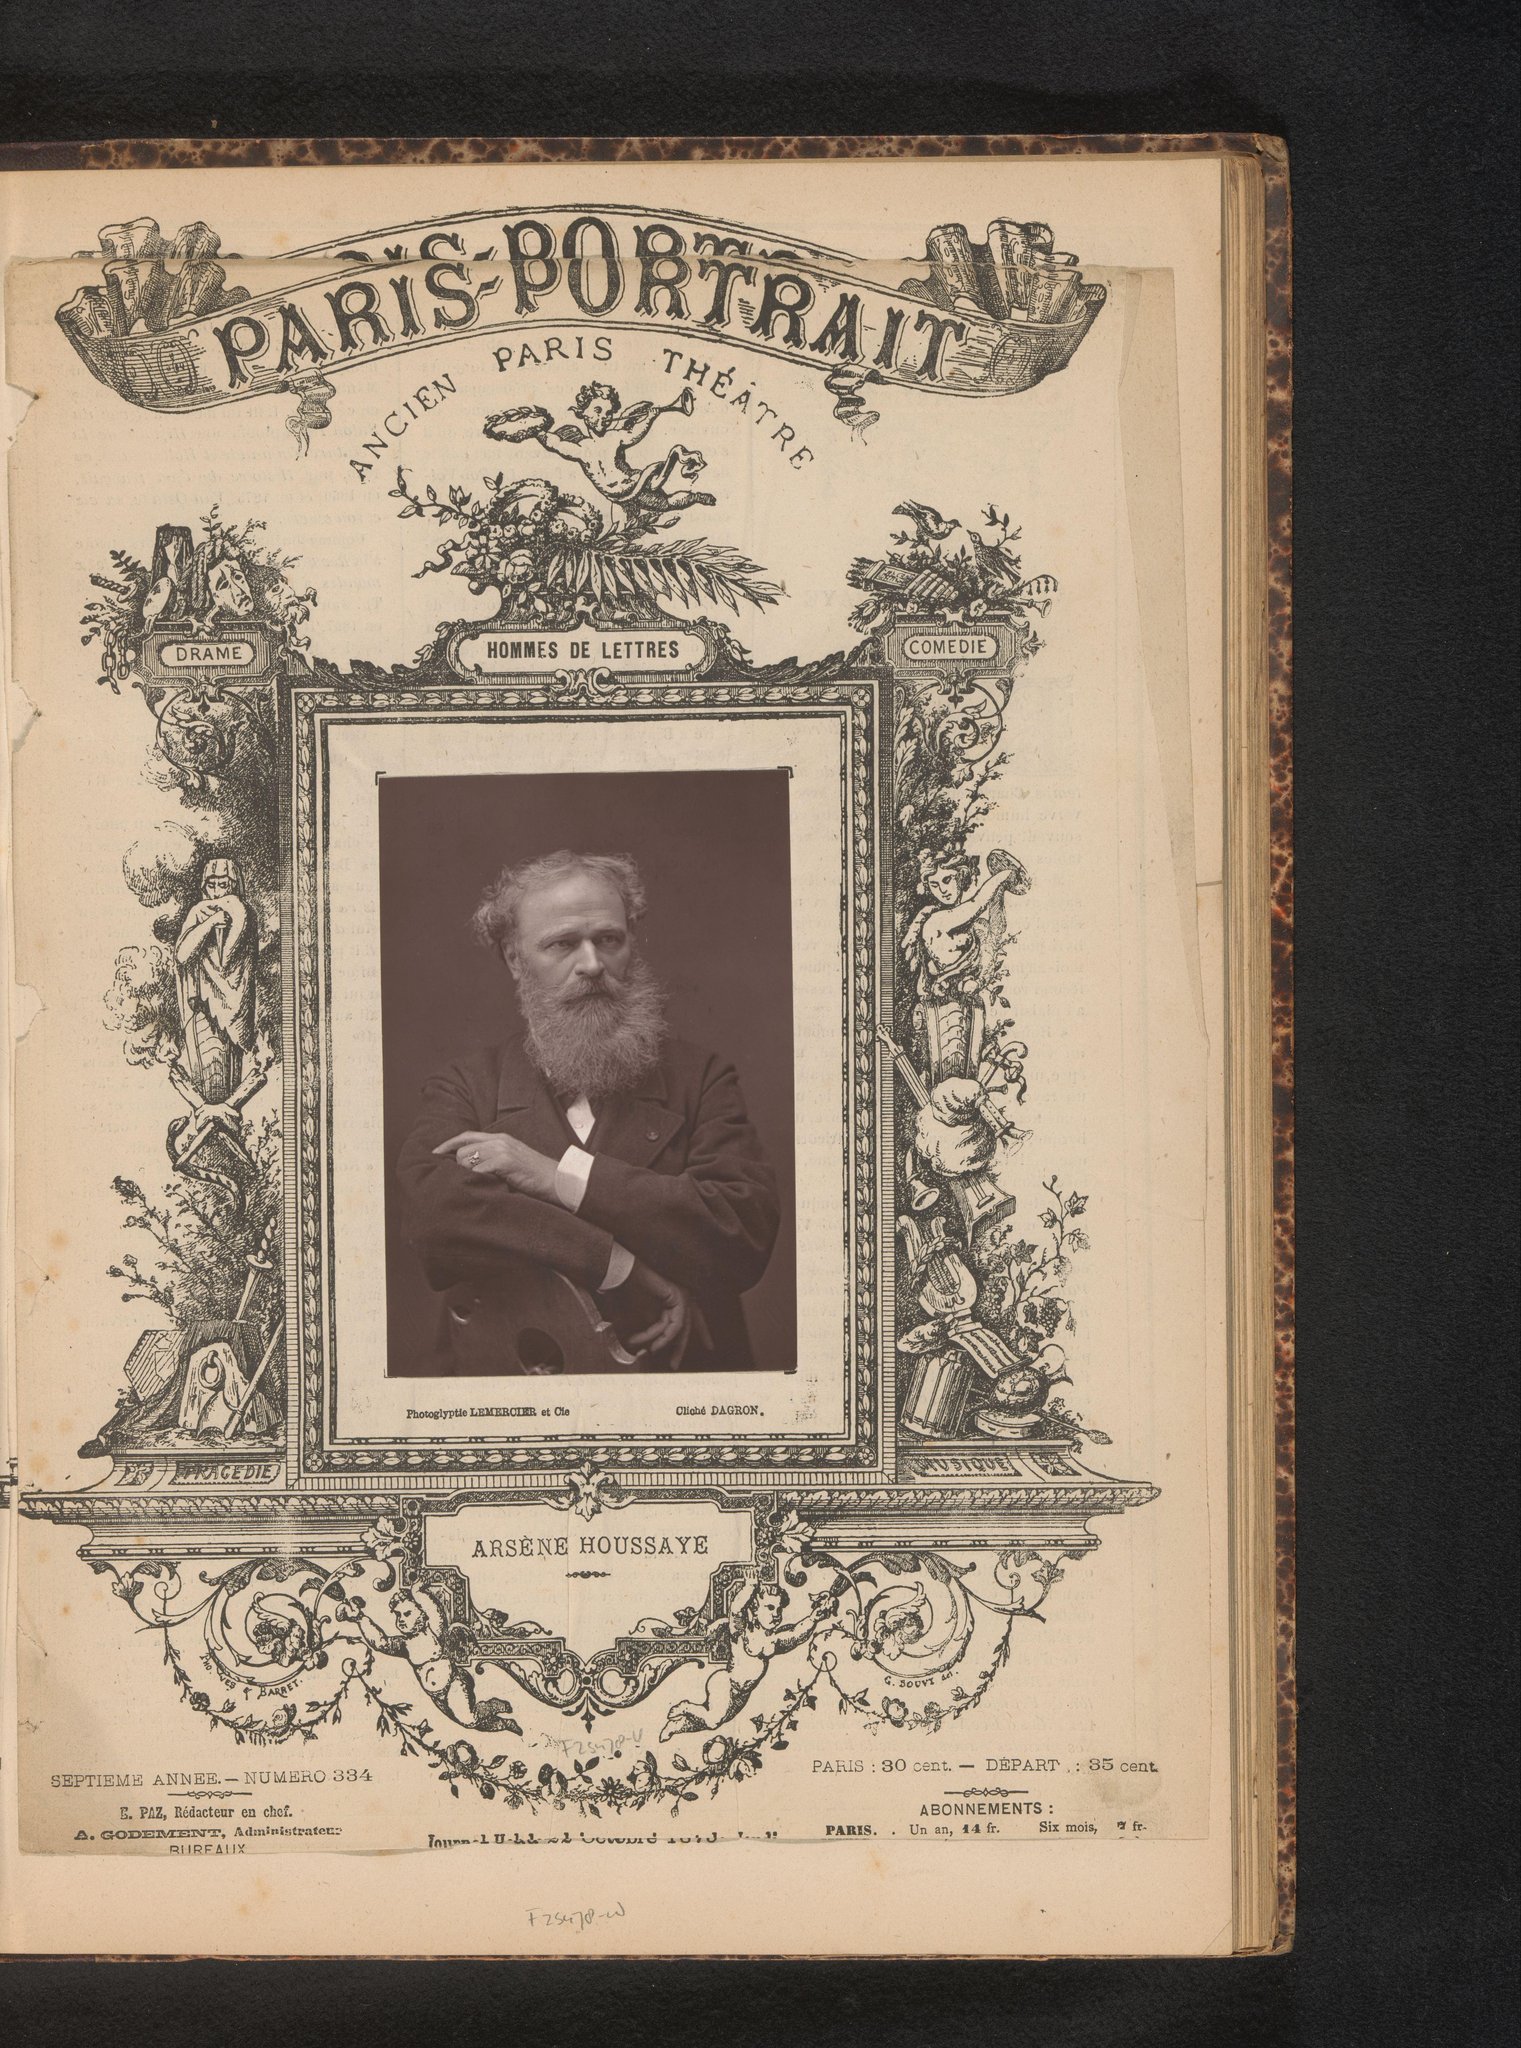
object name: photomechanical print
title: Arsène Houssaye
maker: prudent rené-patrice dagron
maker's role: fotograaf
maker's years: 1819-1900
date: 1873-1880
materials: paper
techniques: woodburytype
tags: paris, arsène houssaye, historical persons